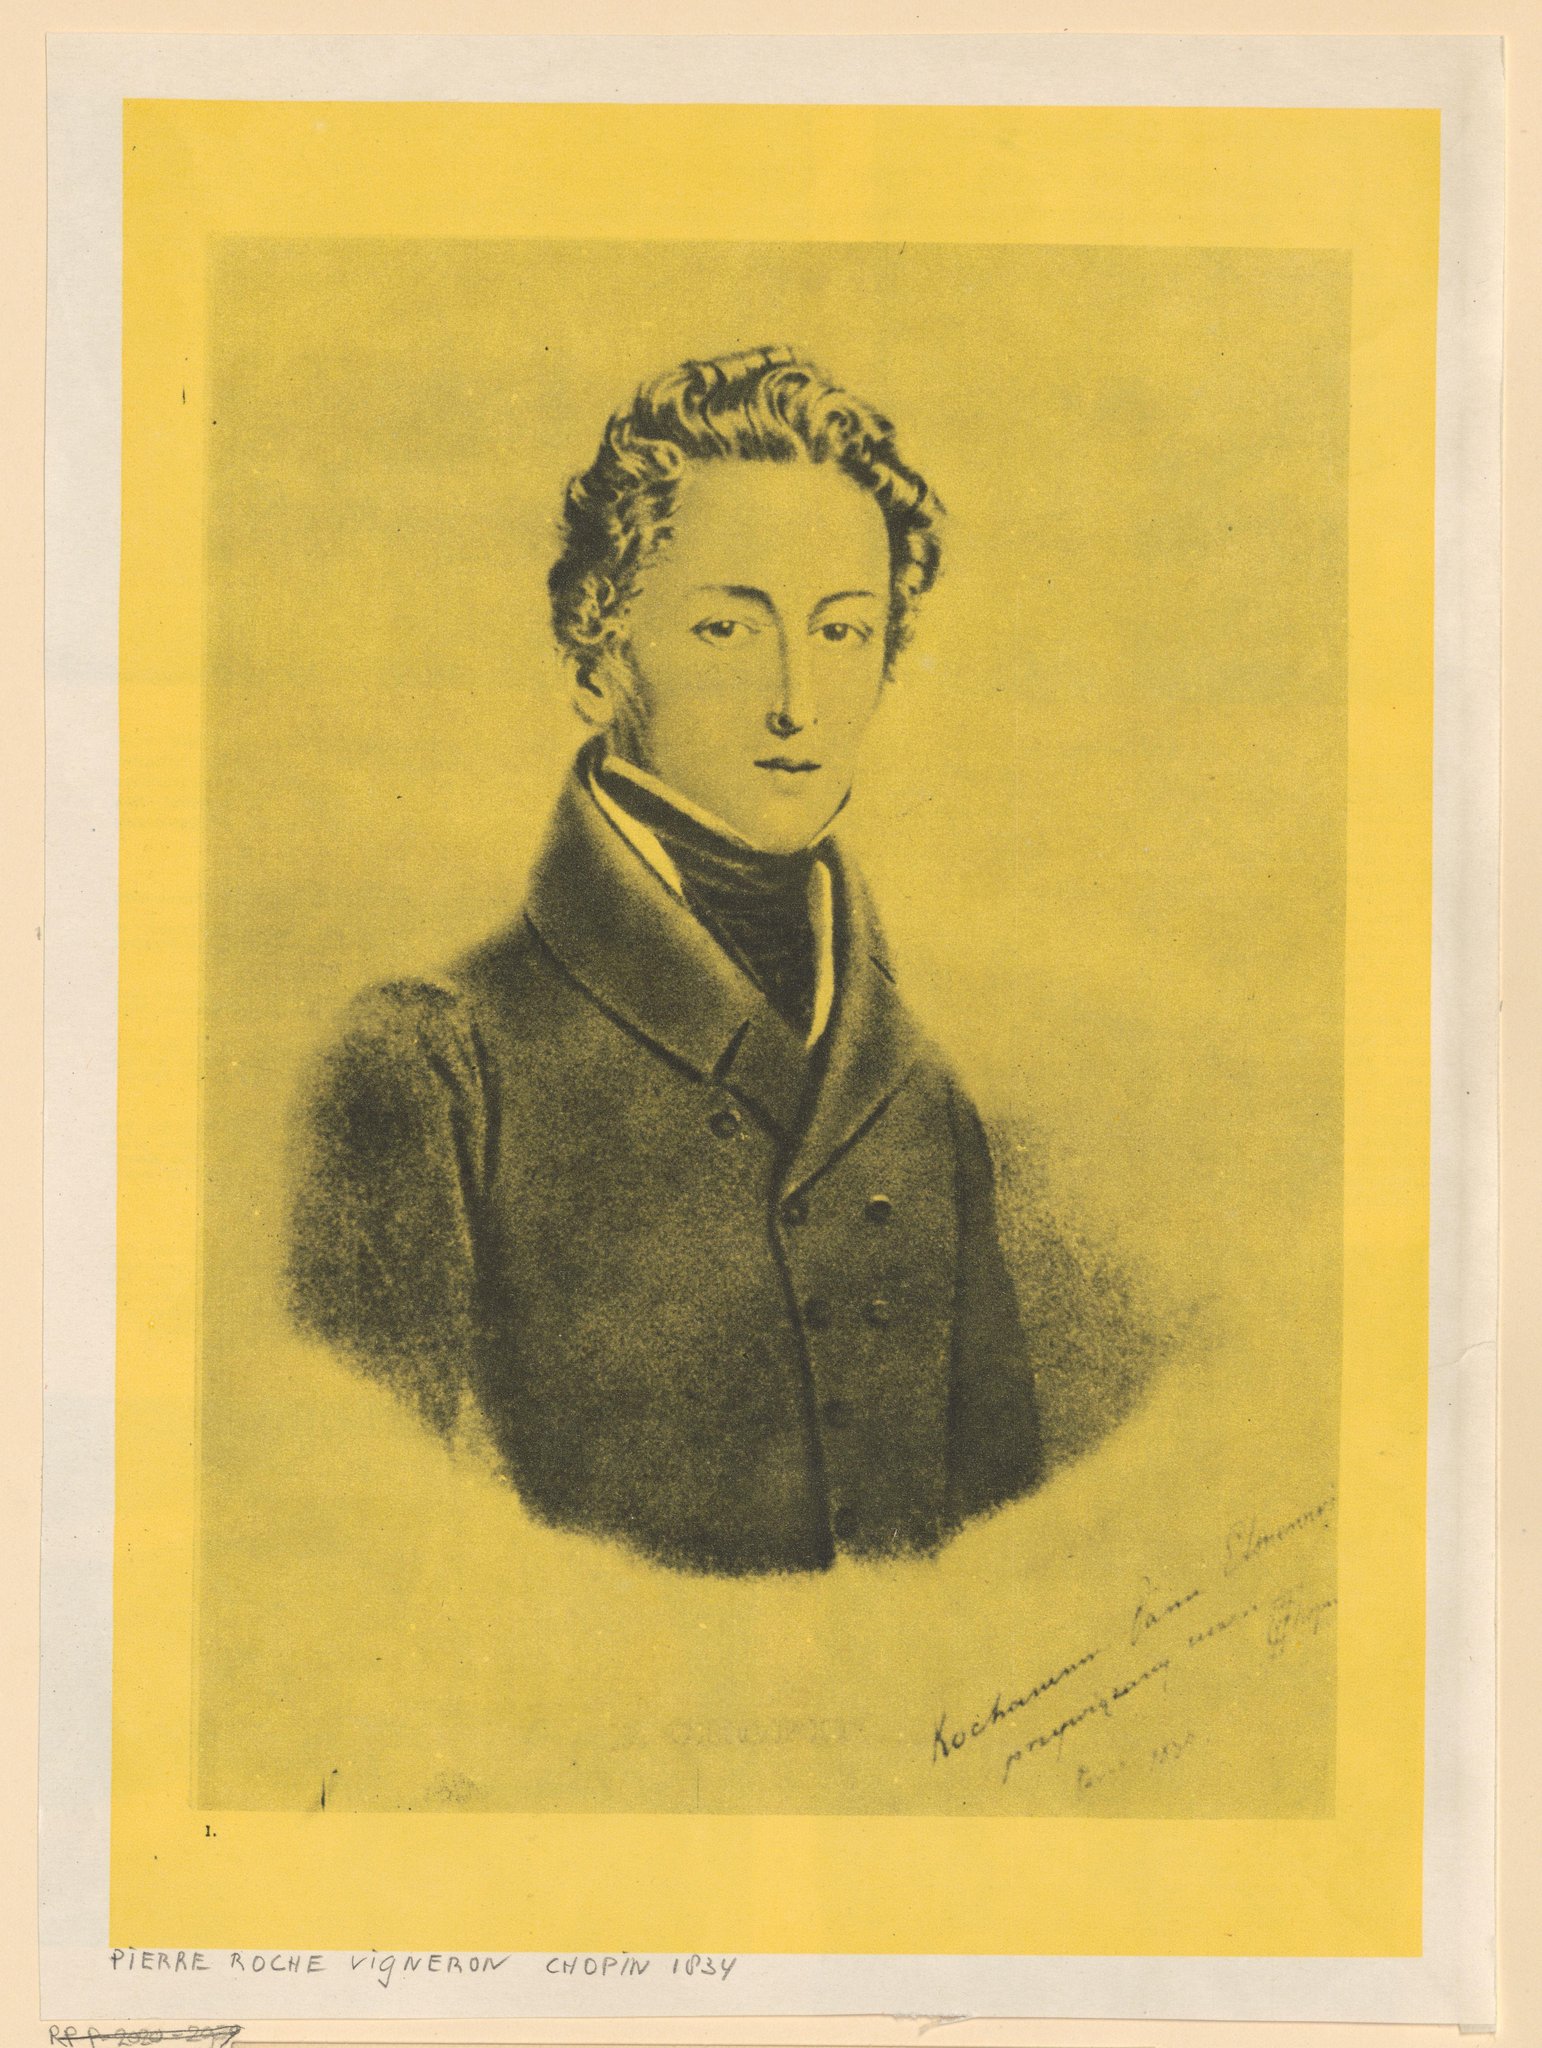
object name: photomechanical print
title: Portret van Frédéric François Chopin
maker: Anonymous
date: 1915-1949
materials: paper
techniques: letterpress printing, lithograph, rotogravure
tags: historical persons, portrait of composer